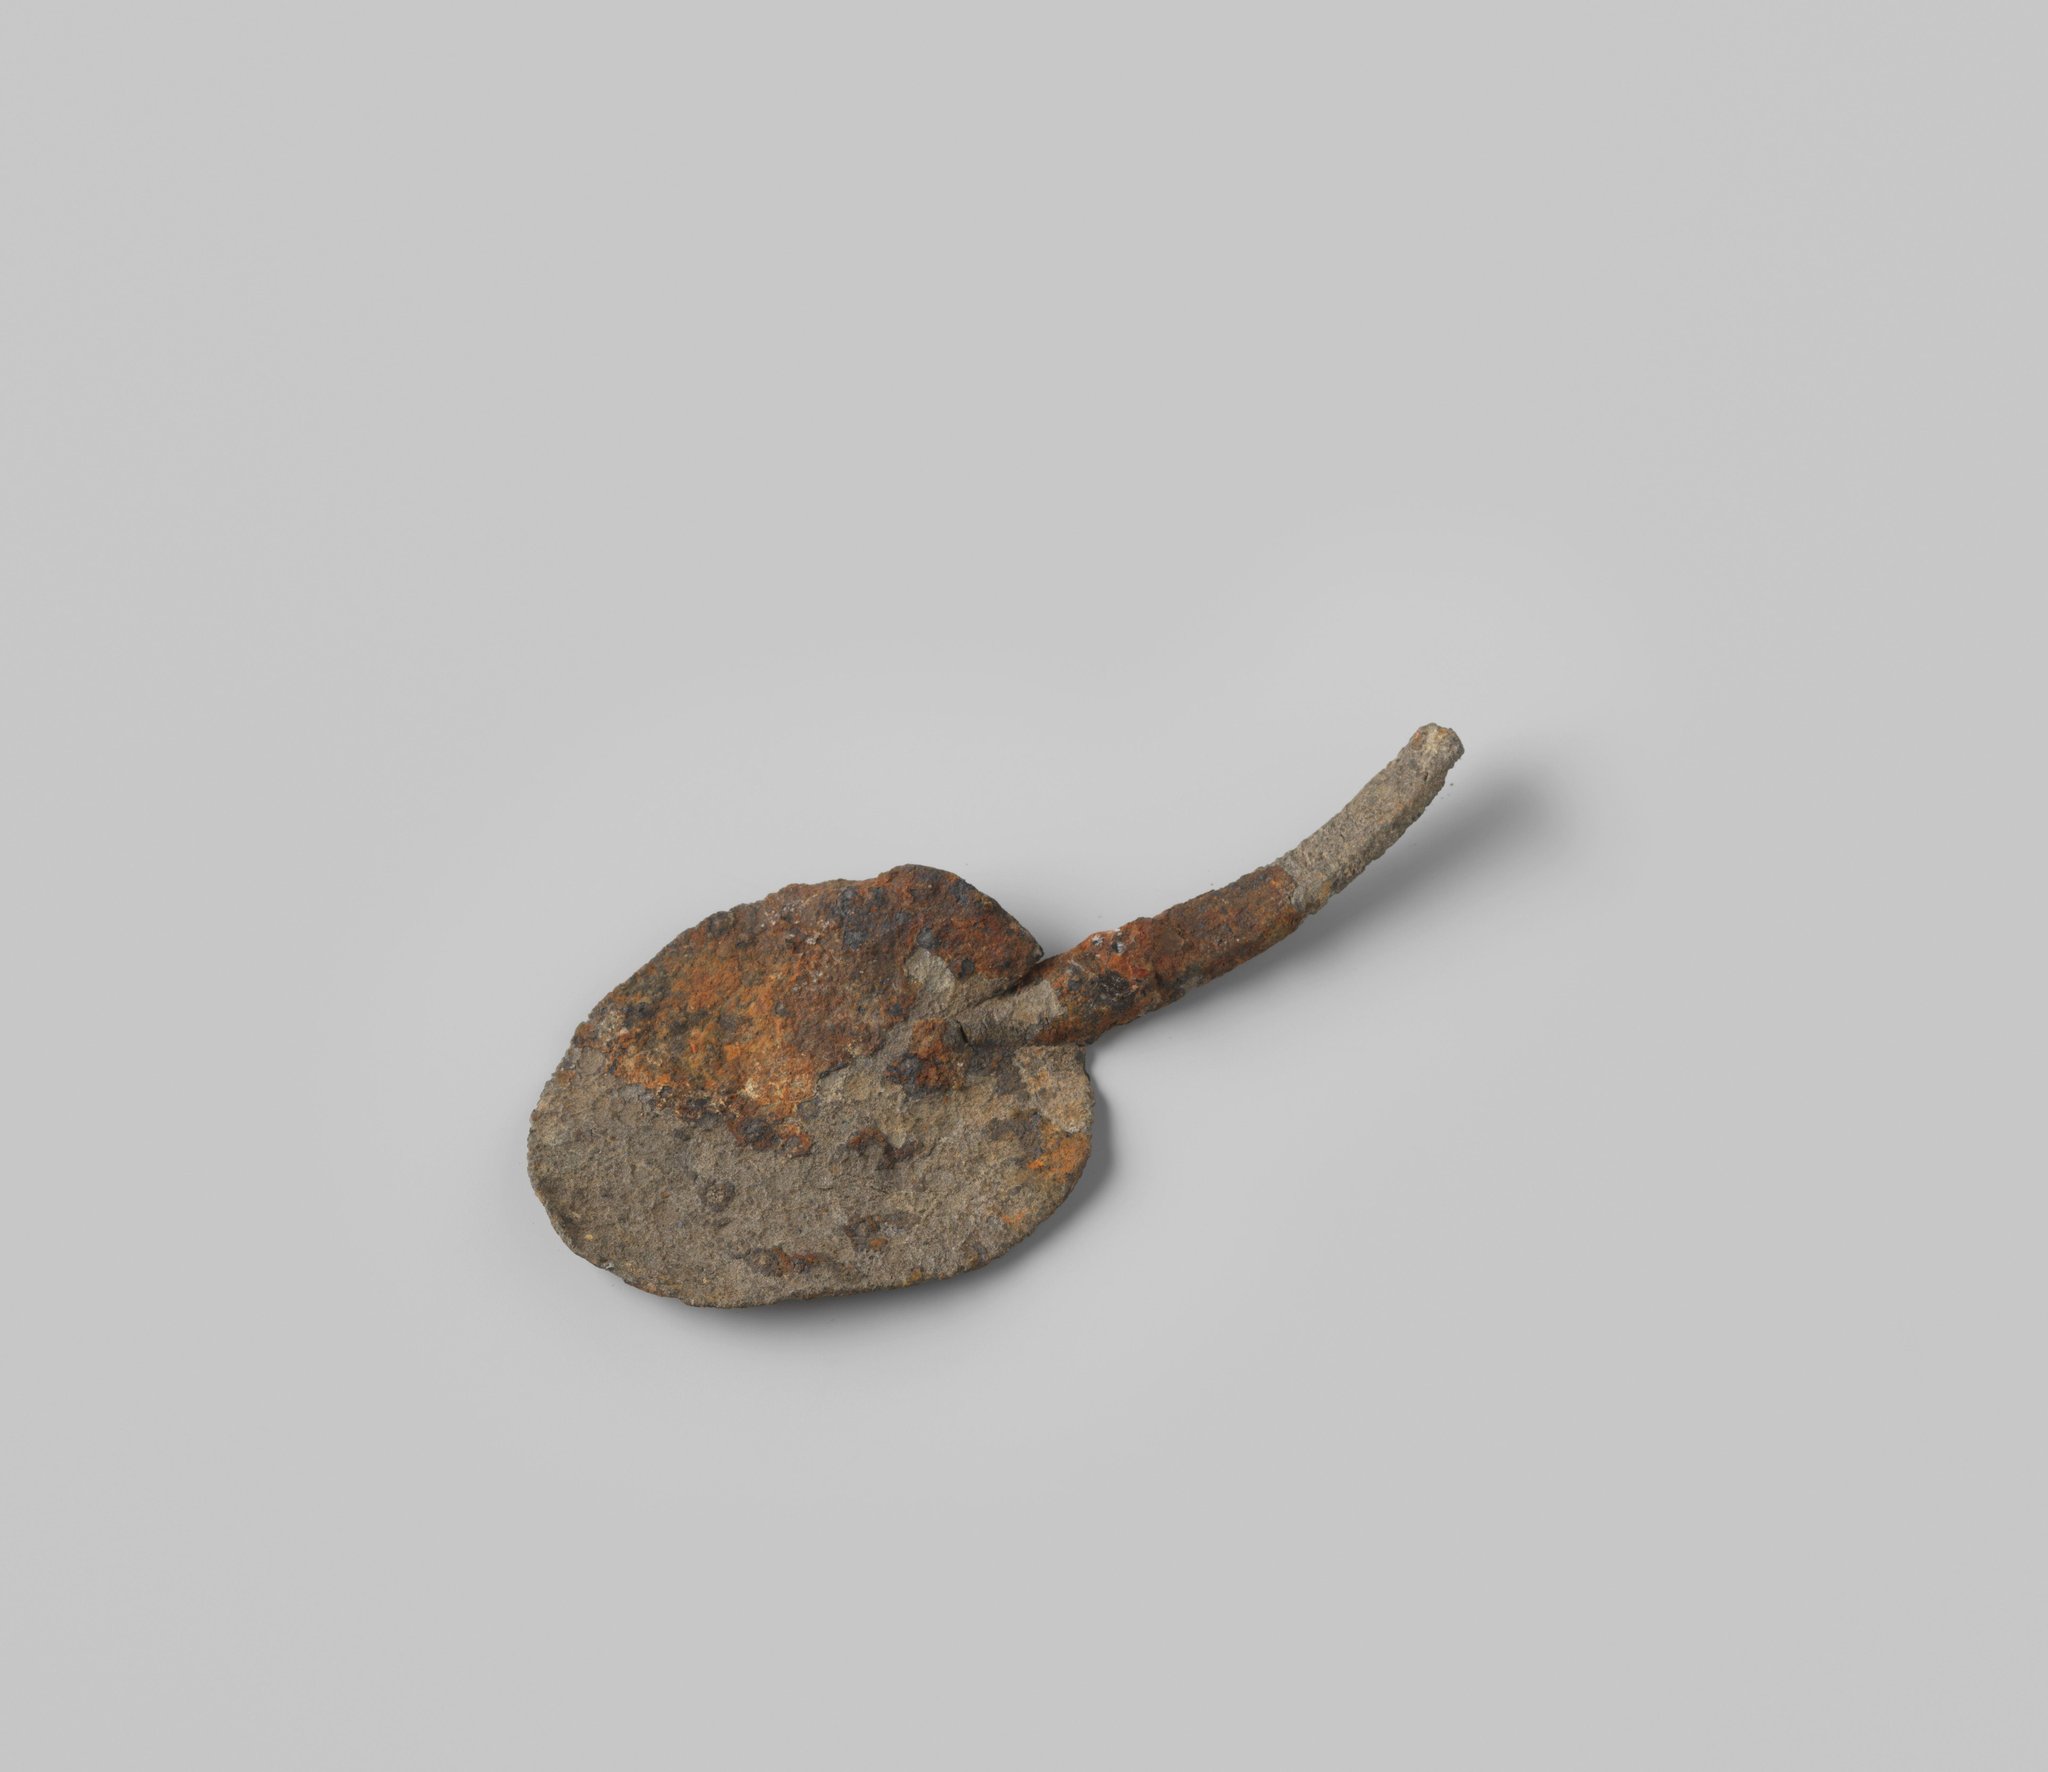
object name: spoon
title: Lepel uit het wrak van de Oost-Indiëvaarder Meresteijn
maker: Anonymous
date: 1693-1702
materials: tin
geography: netherlands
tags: cape of good hope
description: Tinnen lepel: platte steel (deel) met ronde geplette lepel, gecorrodeerd.